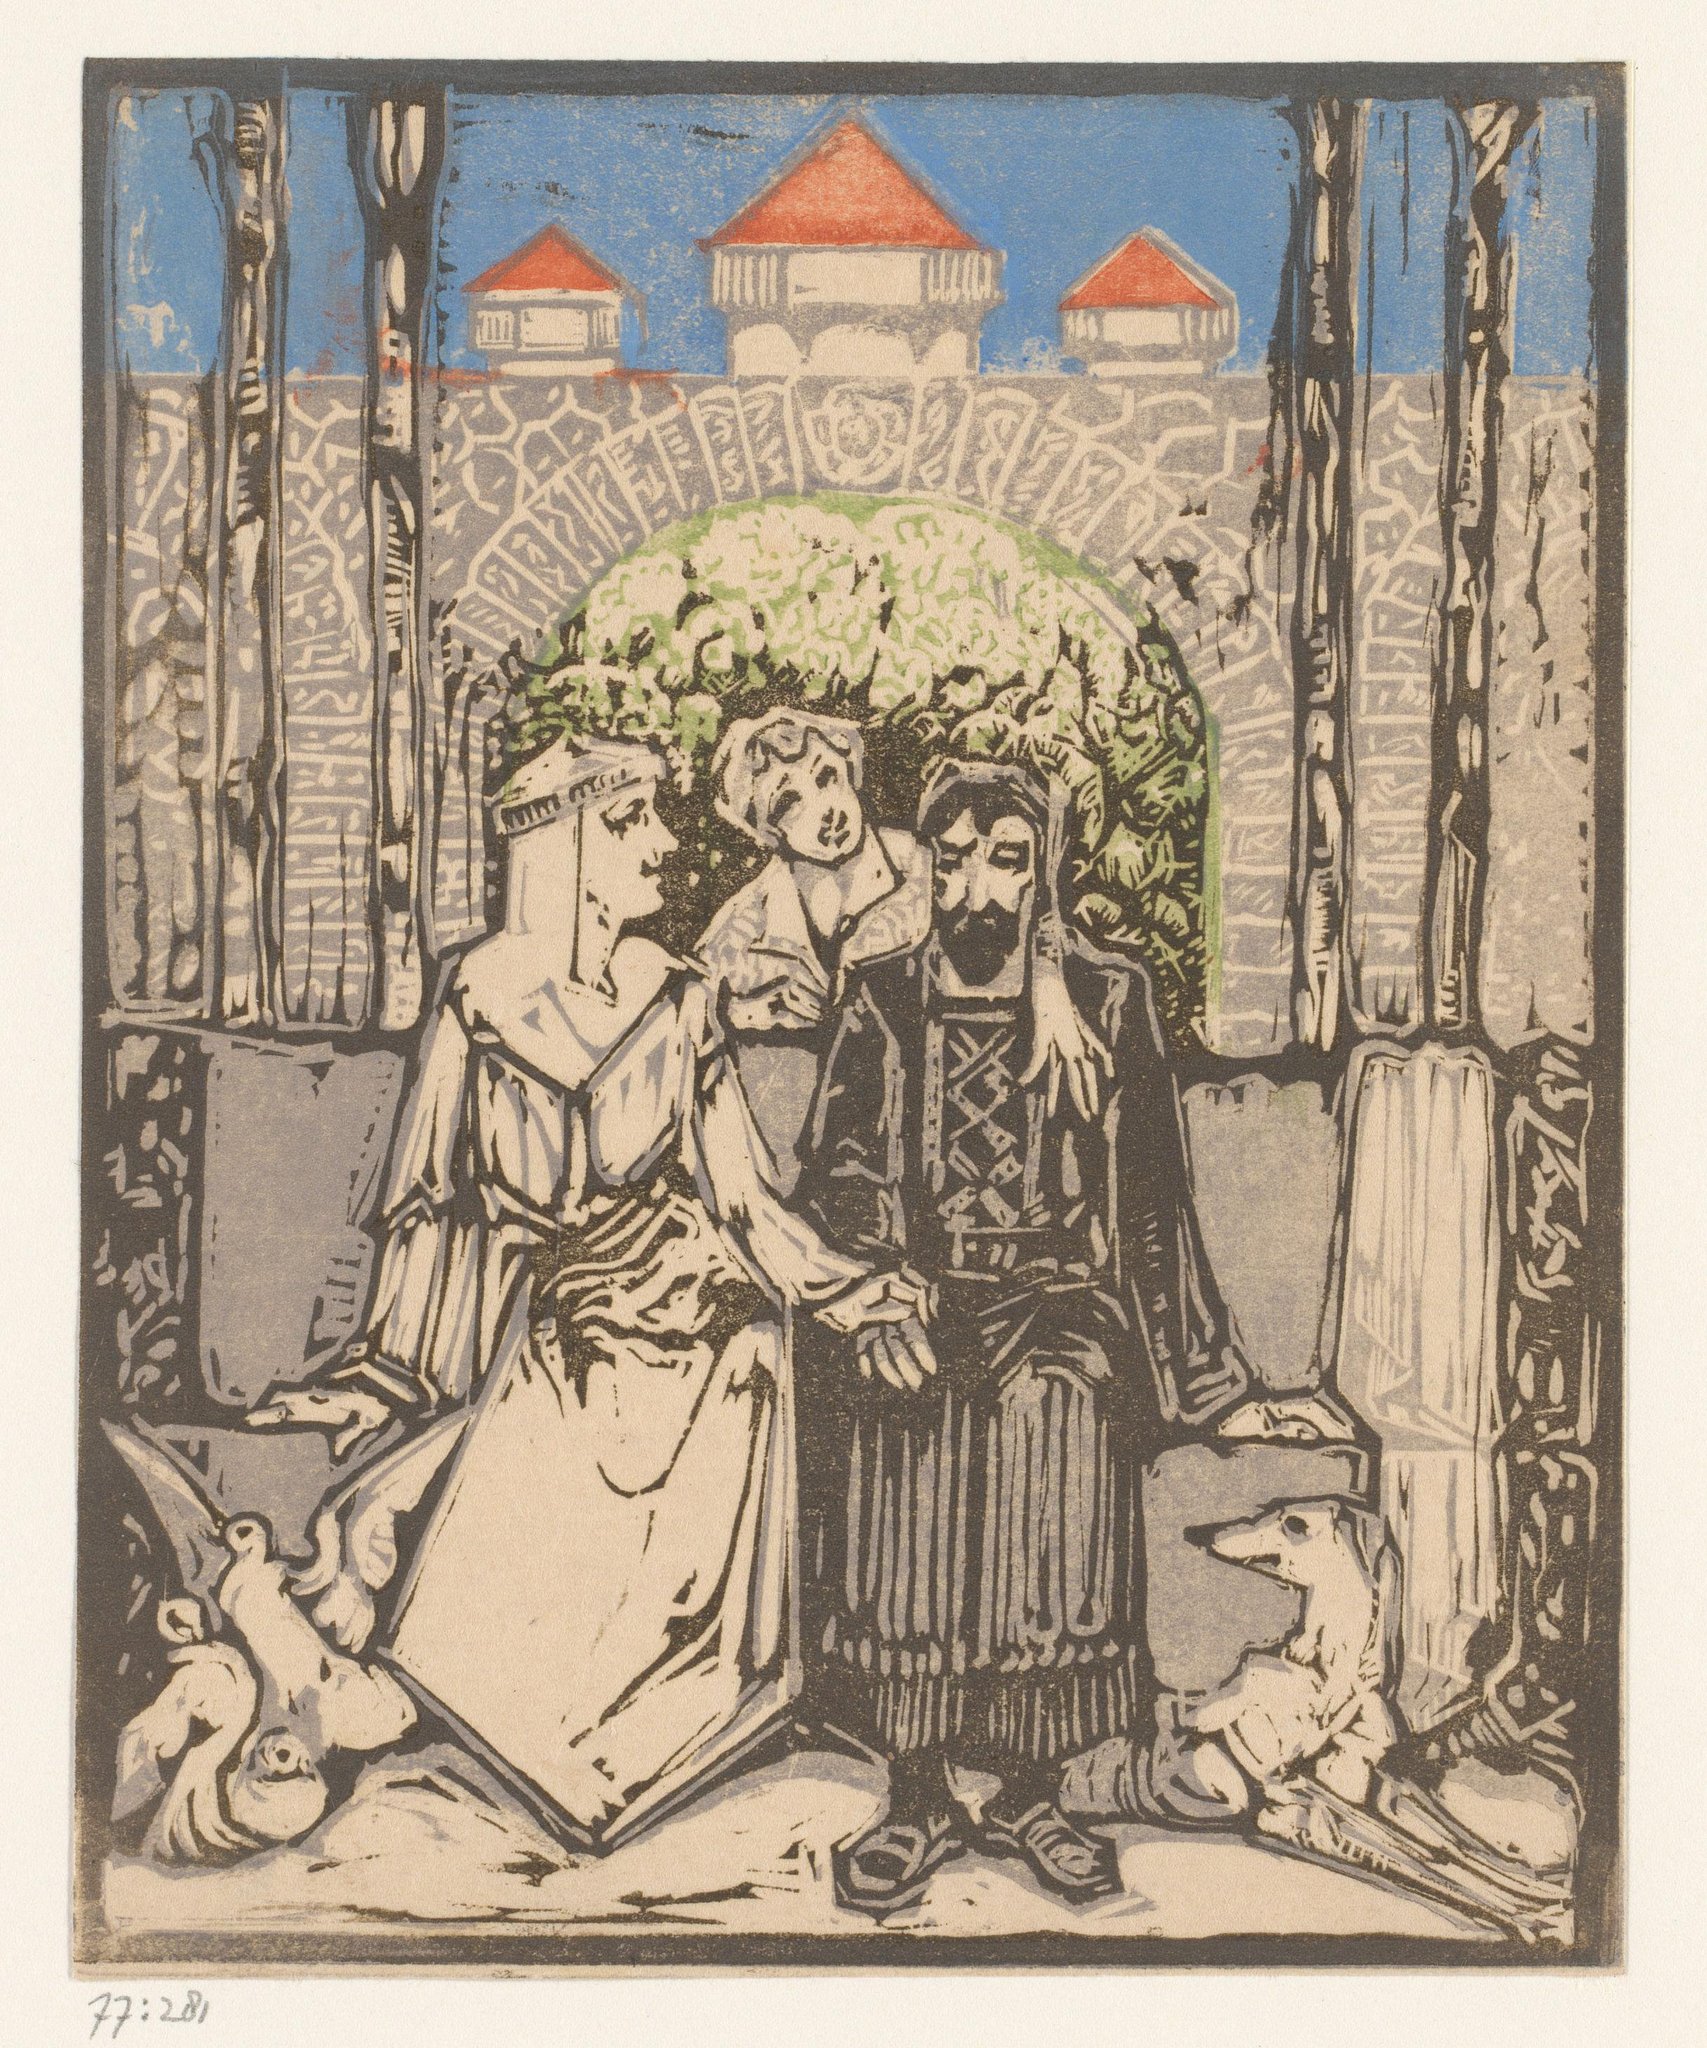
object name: print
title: Zittend paar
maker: bernard willem wierink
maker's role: draughtsman, print maker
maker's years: 1856-1939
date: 1938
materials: paper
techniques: relief print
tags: other birds: dove, couple of lovers, dog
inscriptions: collector's mark: Lugt 2228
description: Illustratie voor een uitgave van een onbekend toneelstuk. Deze prent is waarschijnlijk een plaatsnede, ook al wordt in de literatuur veelal gesproken over een houtsnede. Voor zover Wierink zijn prenten in hoogdruk zelf heeft omschreven, heeft hij altijd de term 'plaatsnede' gebruikt.